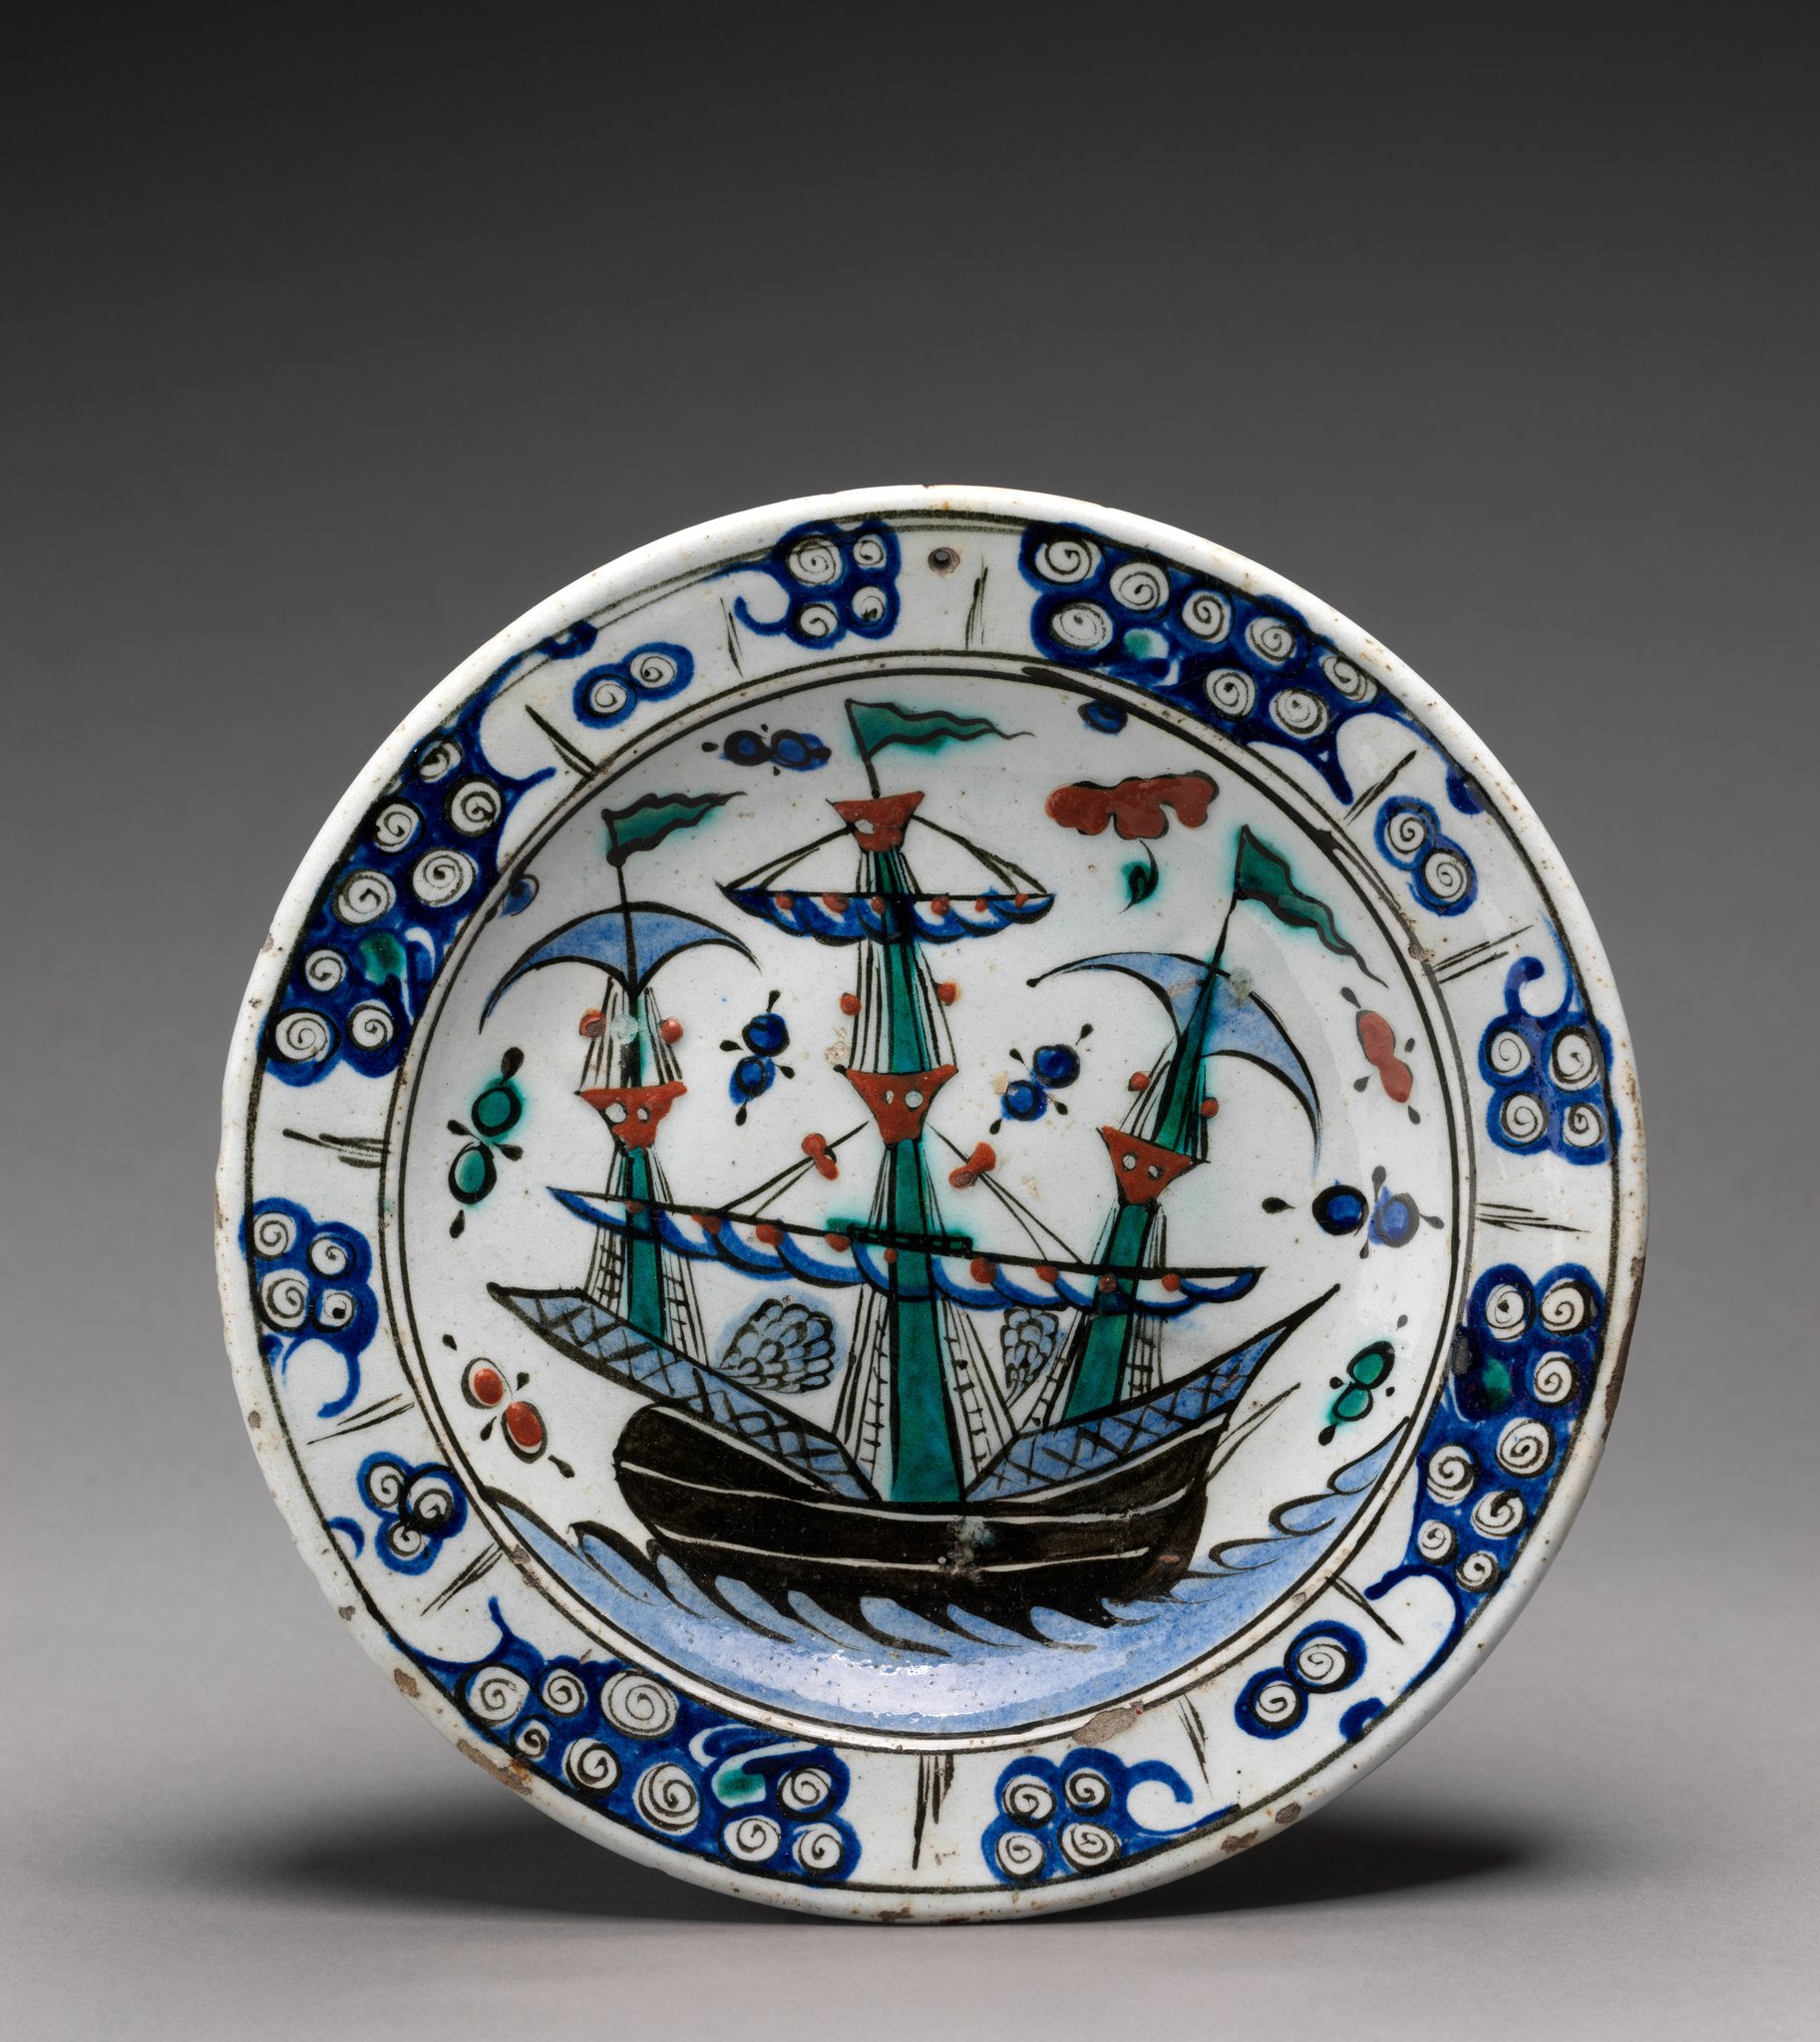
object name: dish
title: Dish with Sailing-Ship Design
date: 1601-1700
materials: glaze, stonepaste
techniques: painting, polychrome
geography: turkey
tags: ships